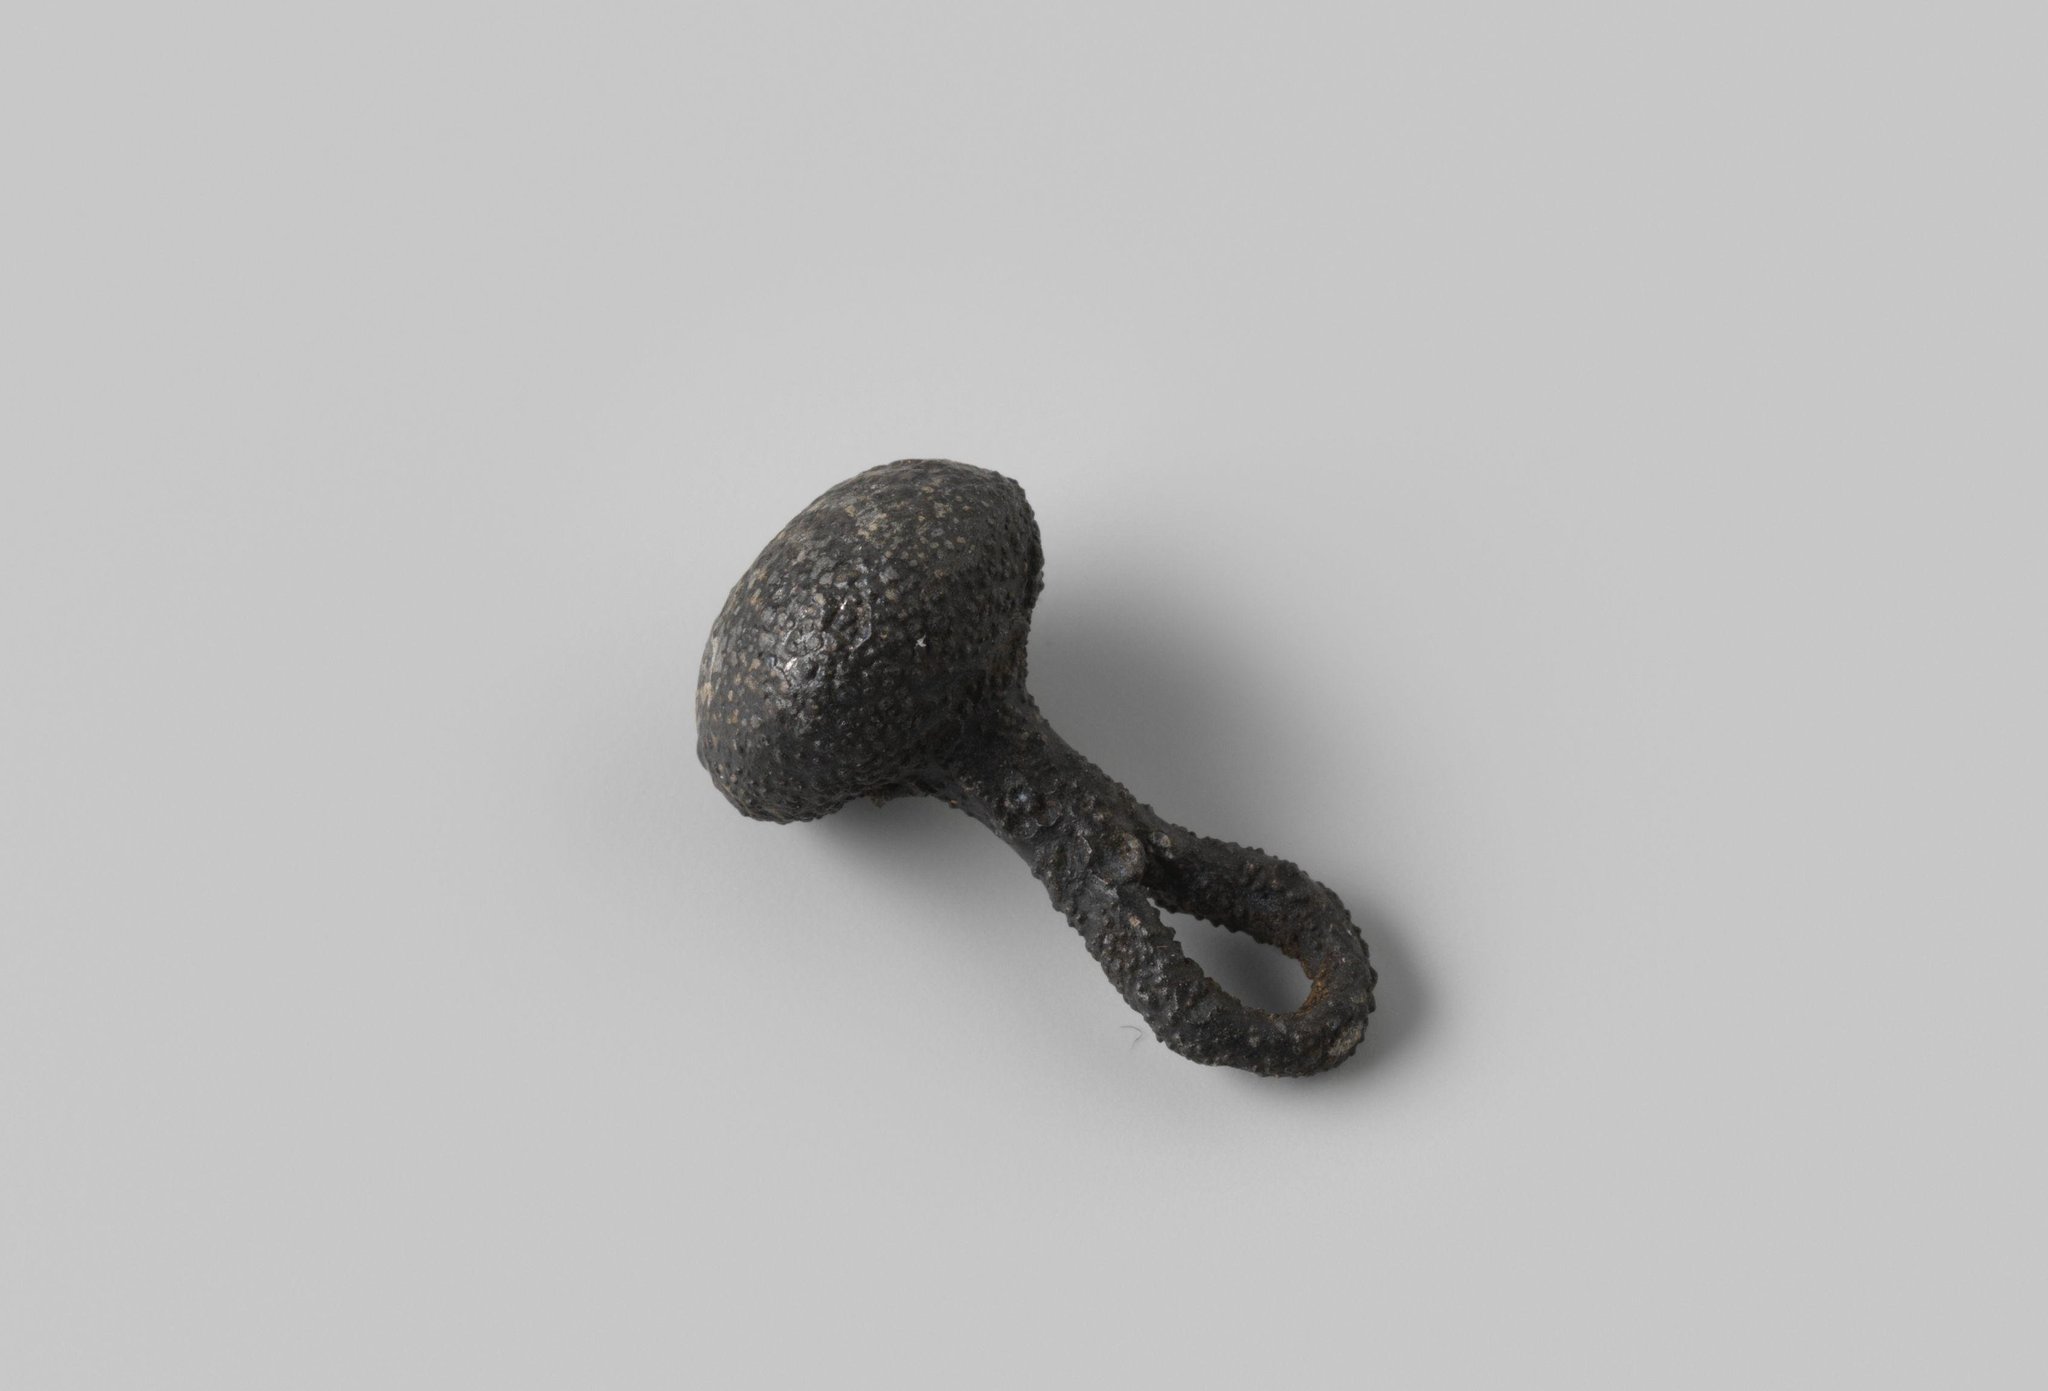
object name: button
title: Knoop uit het wrak van de Oost-Indiëvaarder Princesse Maria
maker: Anonymous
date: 1670-1686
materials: tin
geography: netherlands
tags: princesse maria (schip), verenigde oostindische compagnie